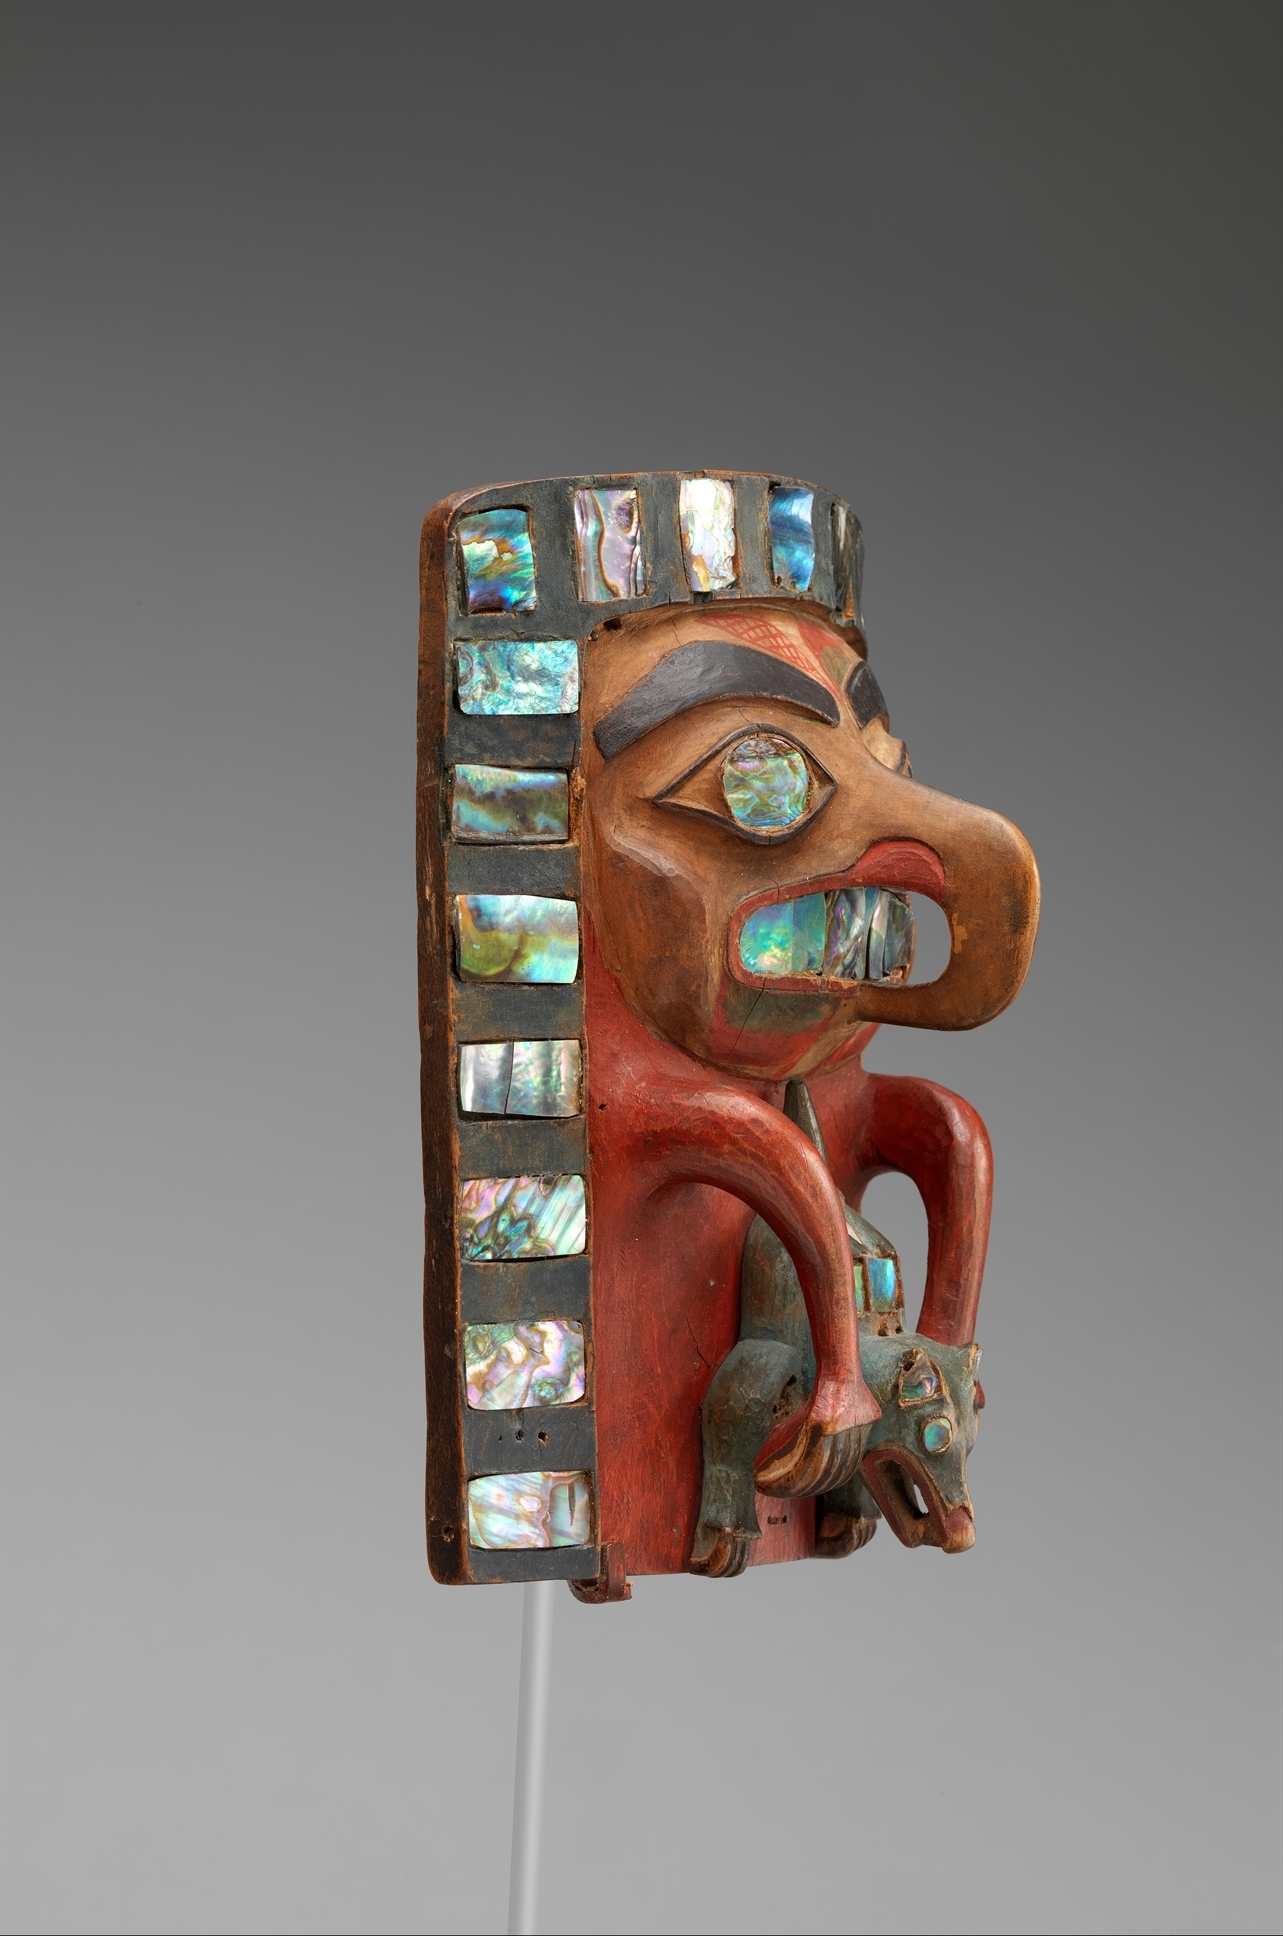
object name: headdress frontlet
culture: tsimshian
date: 1880-1890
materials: paint, shell, wood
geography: canada